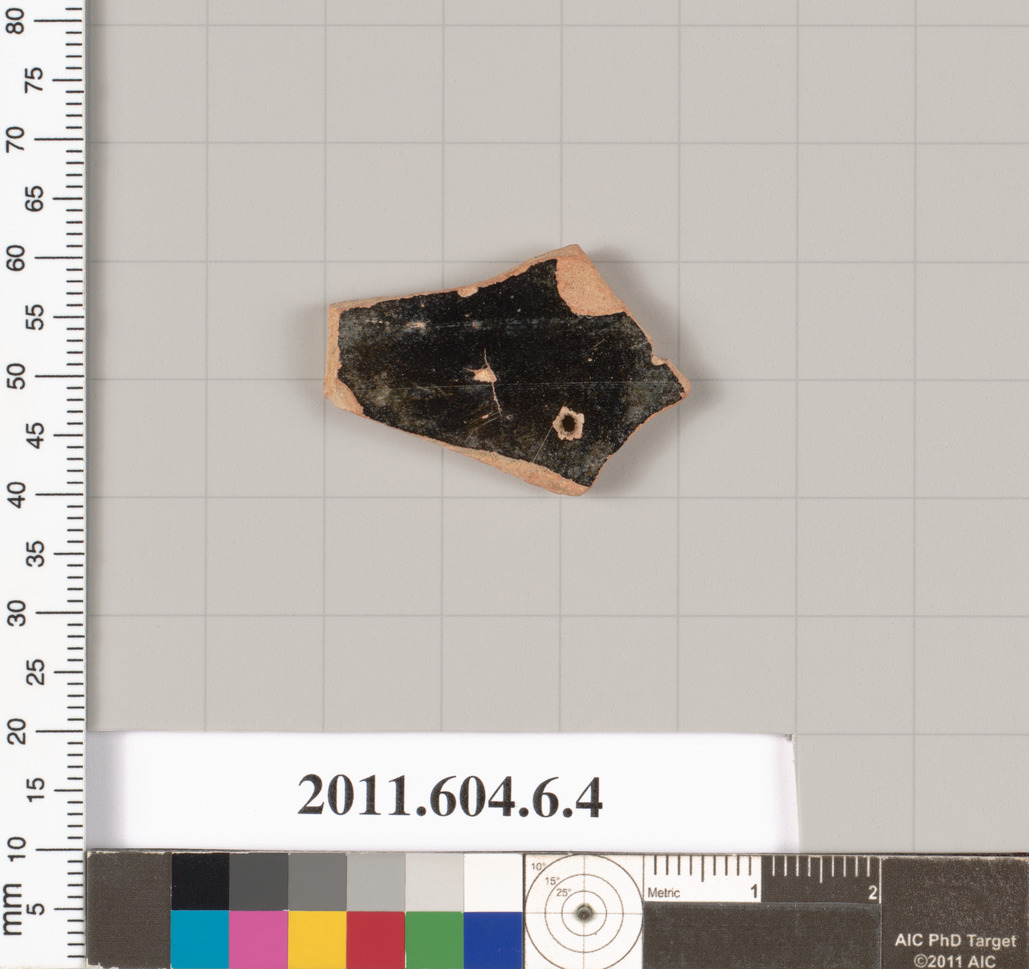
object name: undetermined closed shape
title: Terracotta fragment of a closed shape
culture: greek, attic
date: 600-401 BCE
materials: terracotta